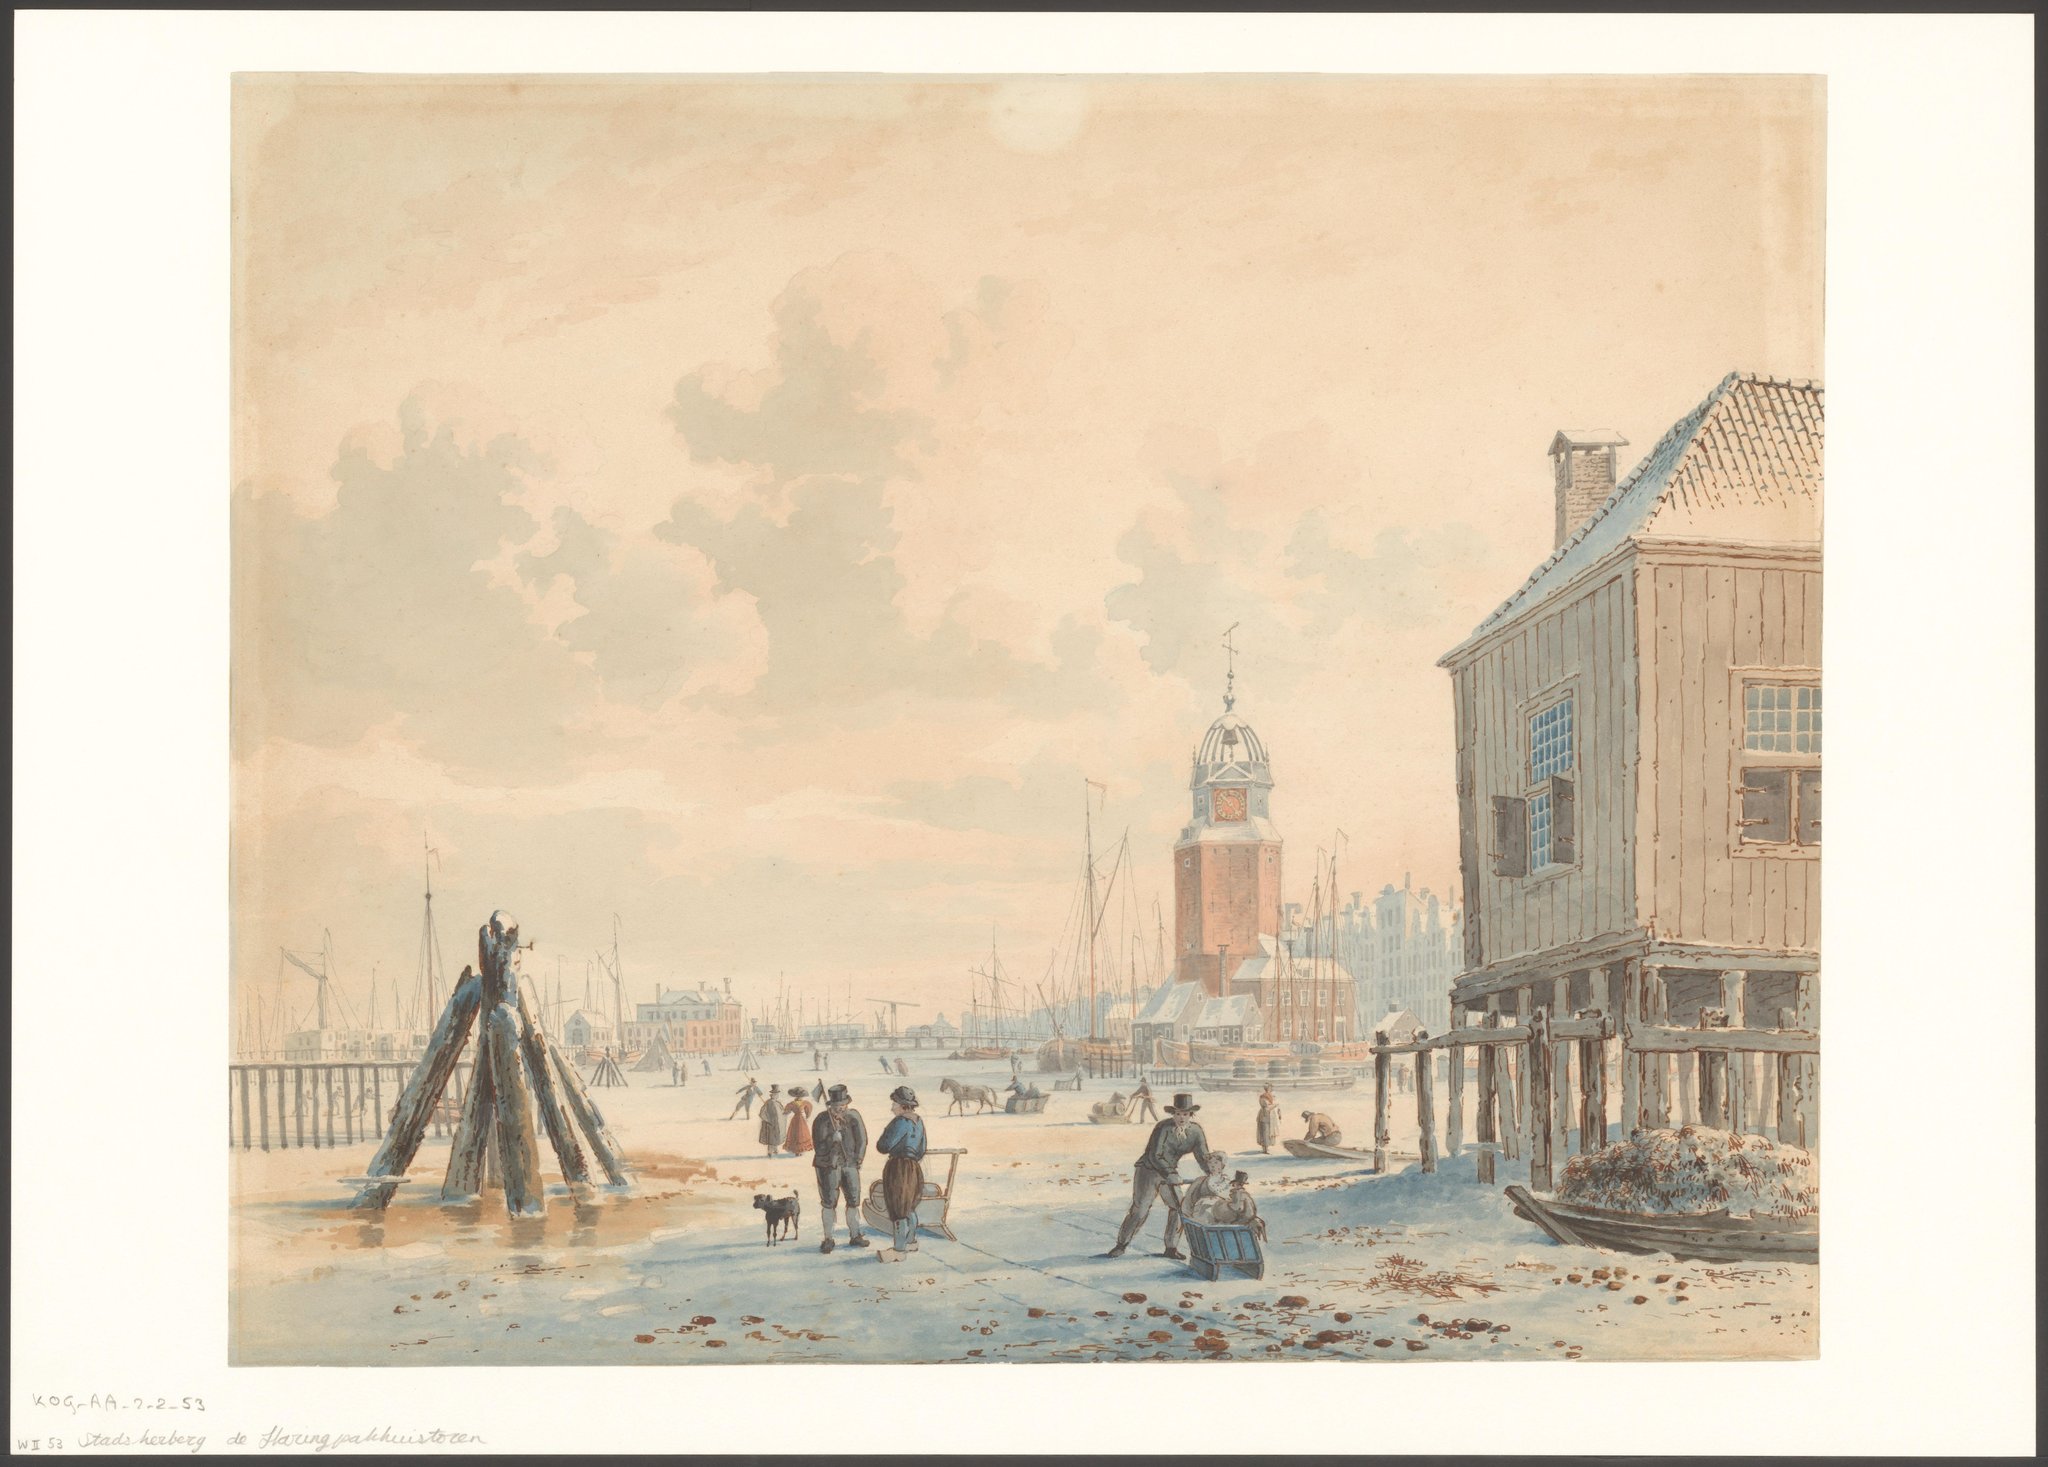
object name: drawing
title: Gezicht op het Open Havenfront gezien naar de Haringpakkerstoren en de Nieuwe Stadsherberg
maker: j. van leeuwen (19de eeuw)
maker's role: draughtsman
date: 1828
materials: ink, paper, pencil, watercolor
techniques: brush, pen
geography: amsterdam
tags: tower, clock tower ~ monumental adornment, city-view in general; 'veduta', river, sleigh, sledge (non-sport), winter landscape; landscape symbolizing winter (the four seasons of the year), hotel, hostelry, inn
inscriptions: inscription: ‘de Haring Pakkers Tooren’, signature and date: ‘Anno 1828. J van Leeuwen del: & Fecit.’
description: Tekening binnen de Atlas Van Eck ingedeeld op wijknummer 2.